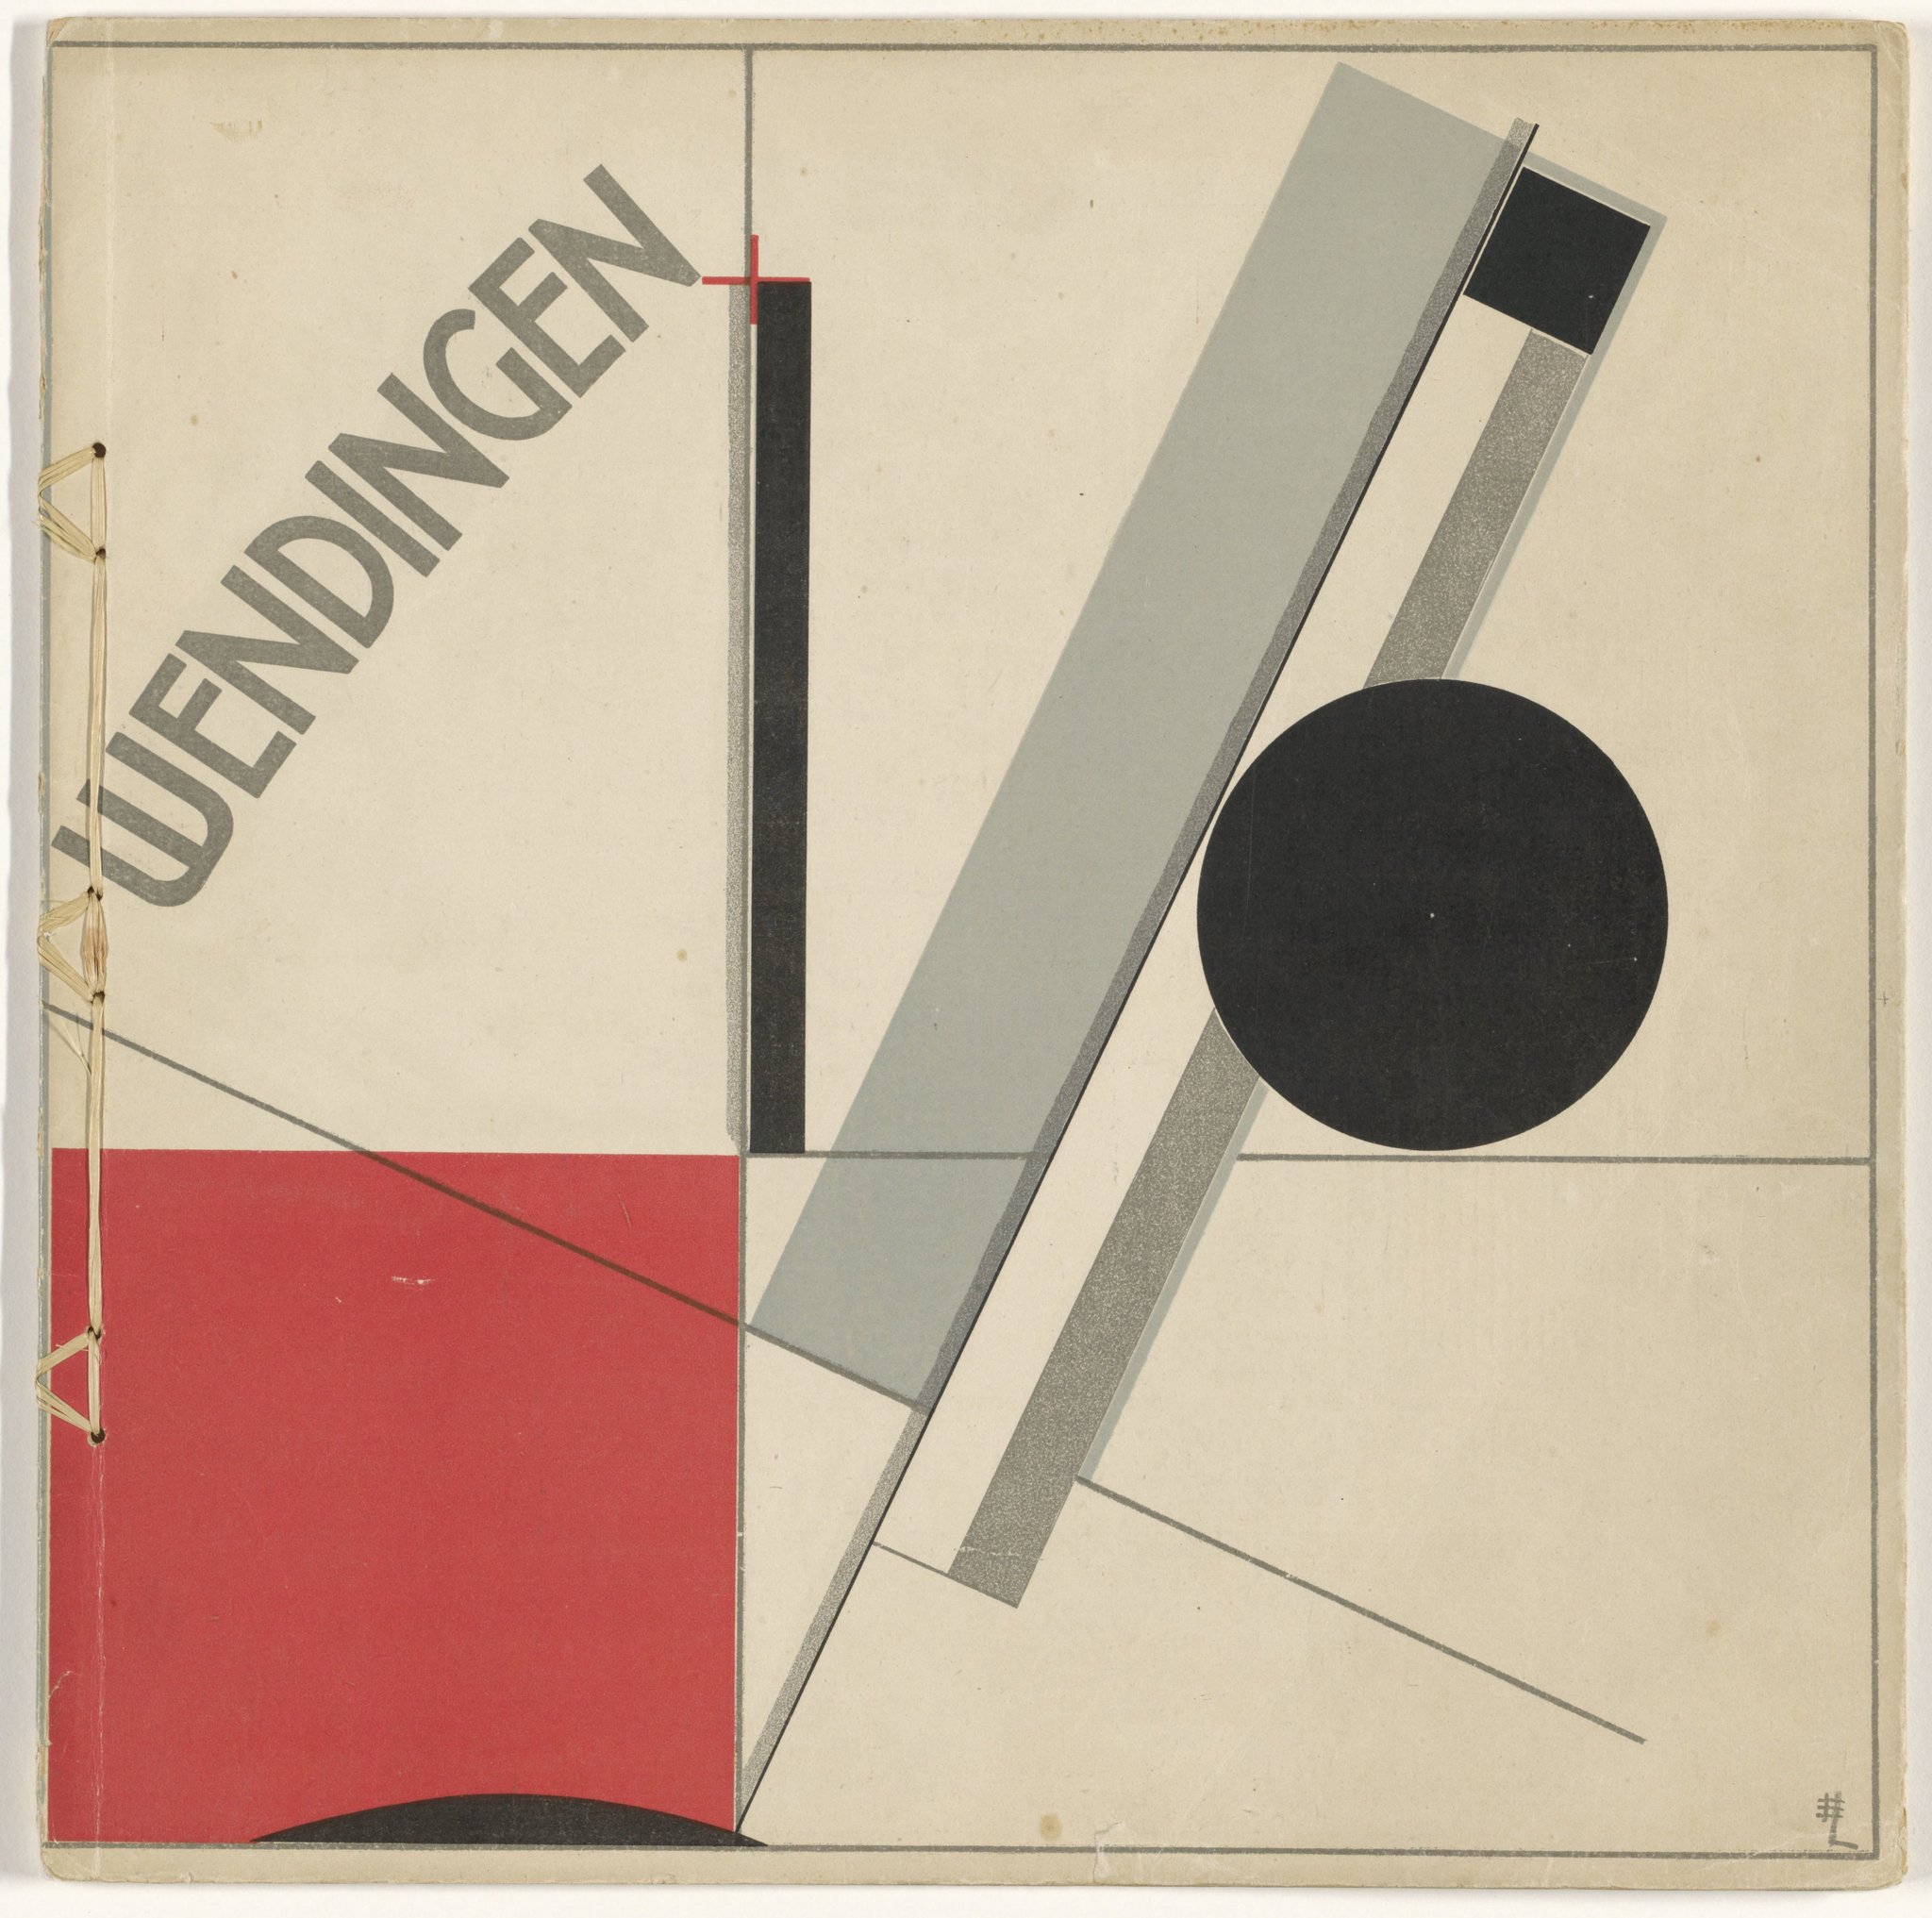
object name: magazine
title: Wendingen, nr. 4, november 1922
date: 1911-1922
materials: paper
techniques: letterpress printing, lithograph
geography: netherlands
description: Vierkant tijdschrift 'Wendingen', nr. 11 van de vierde jaargang (1921), gewijd aan het werk van de Amerikaanse architect Frank Lloyd Wright met een gelithografeerd omslag naar een origineel ontwerp van de Russische kunstenaar El Lissitzky.